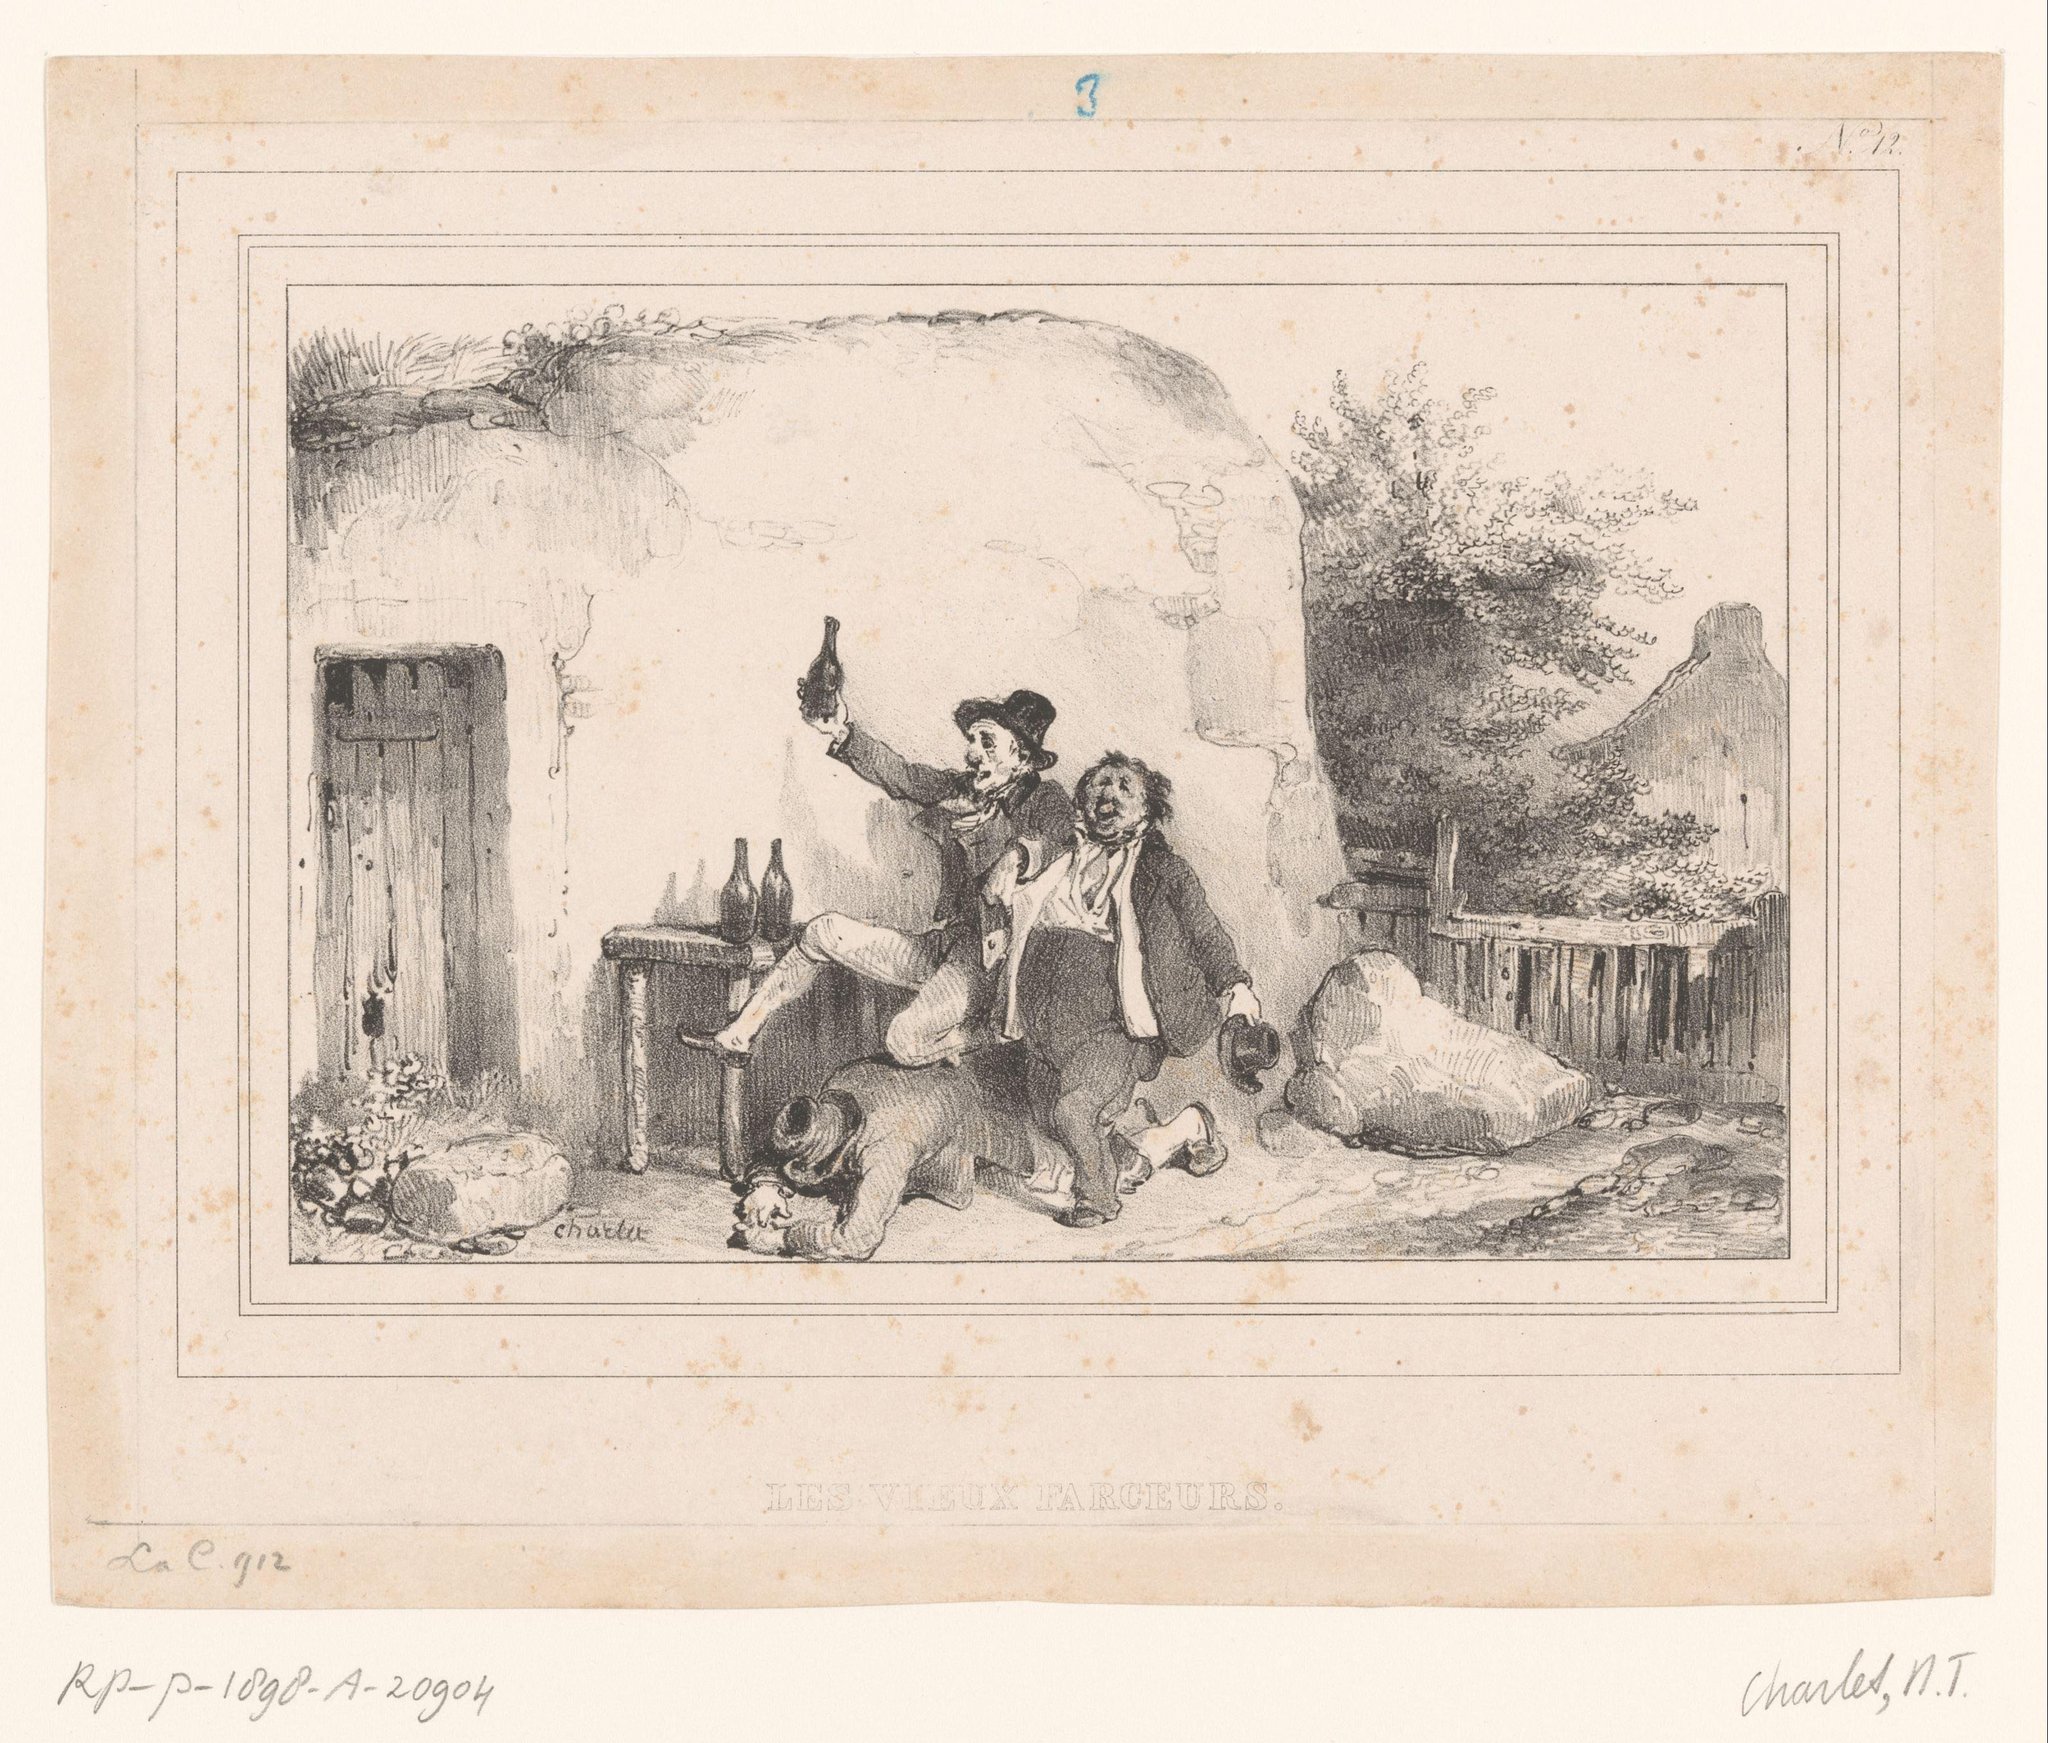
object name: print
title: Croquis par Charlet 1837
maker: nicolas toussaint charlet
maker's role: draughtsman, painter, print maker, printer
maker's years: 1792-1845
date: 1837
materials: paper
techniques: lithograph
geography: paris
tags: drunkard, rural life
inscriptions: collector's mark: Lugt 2228a